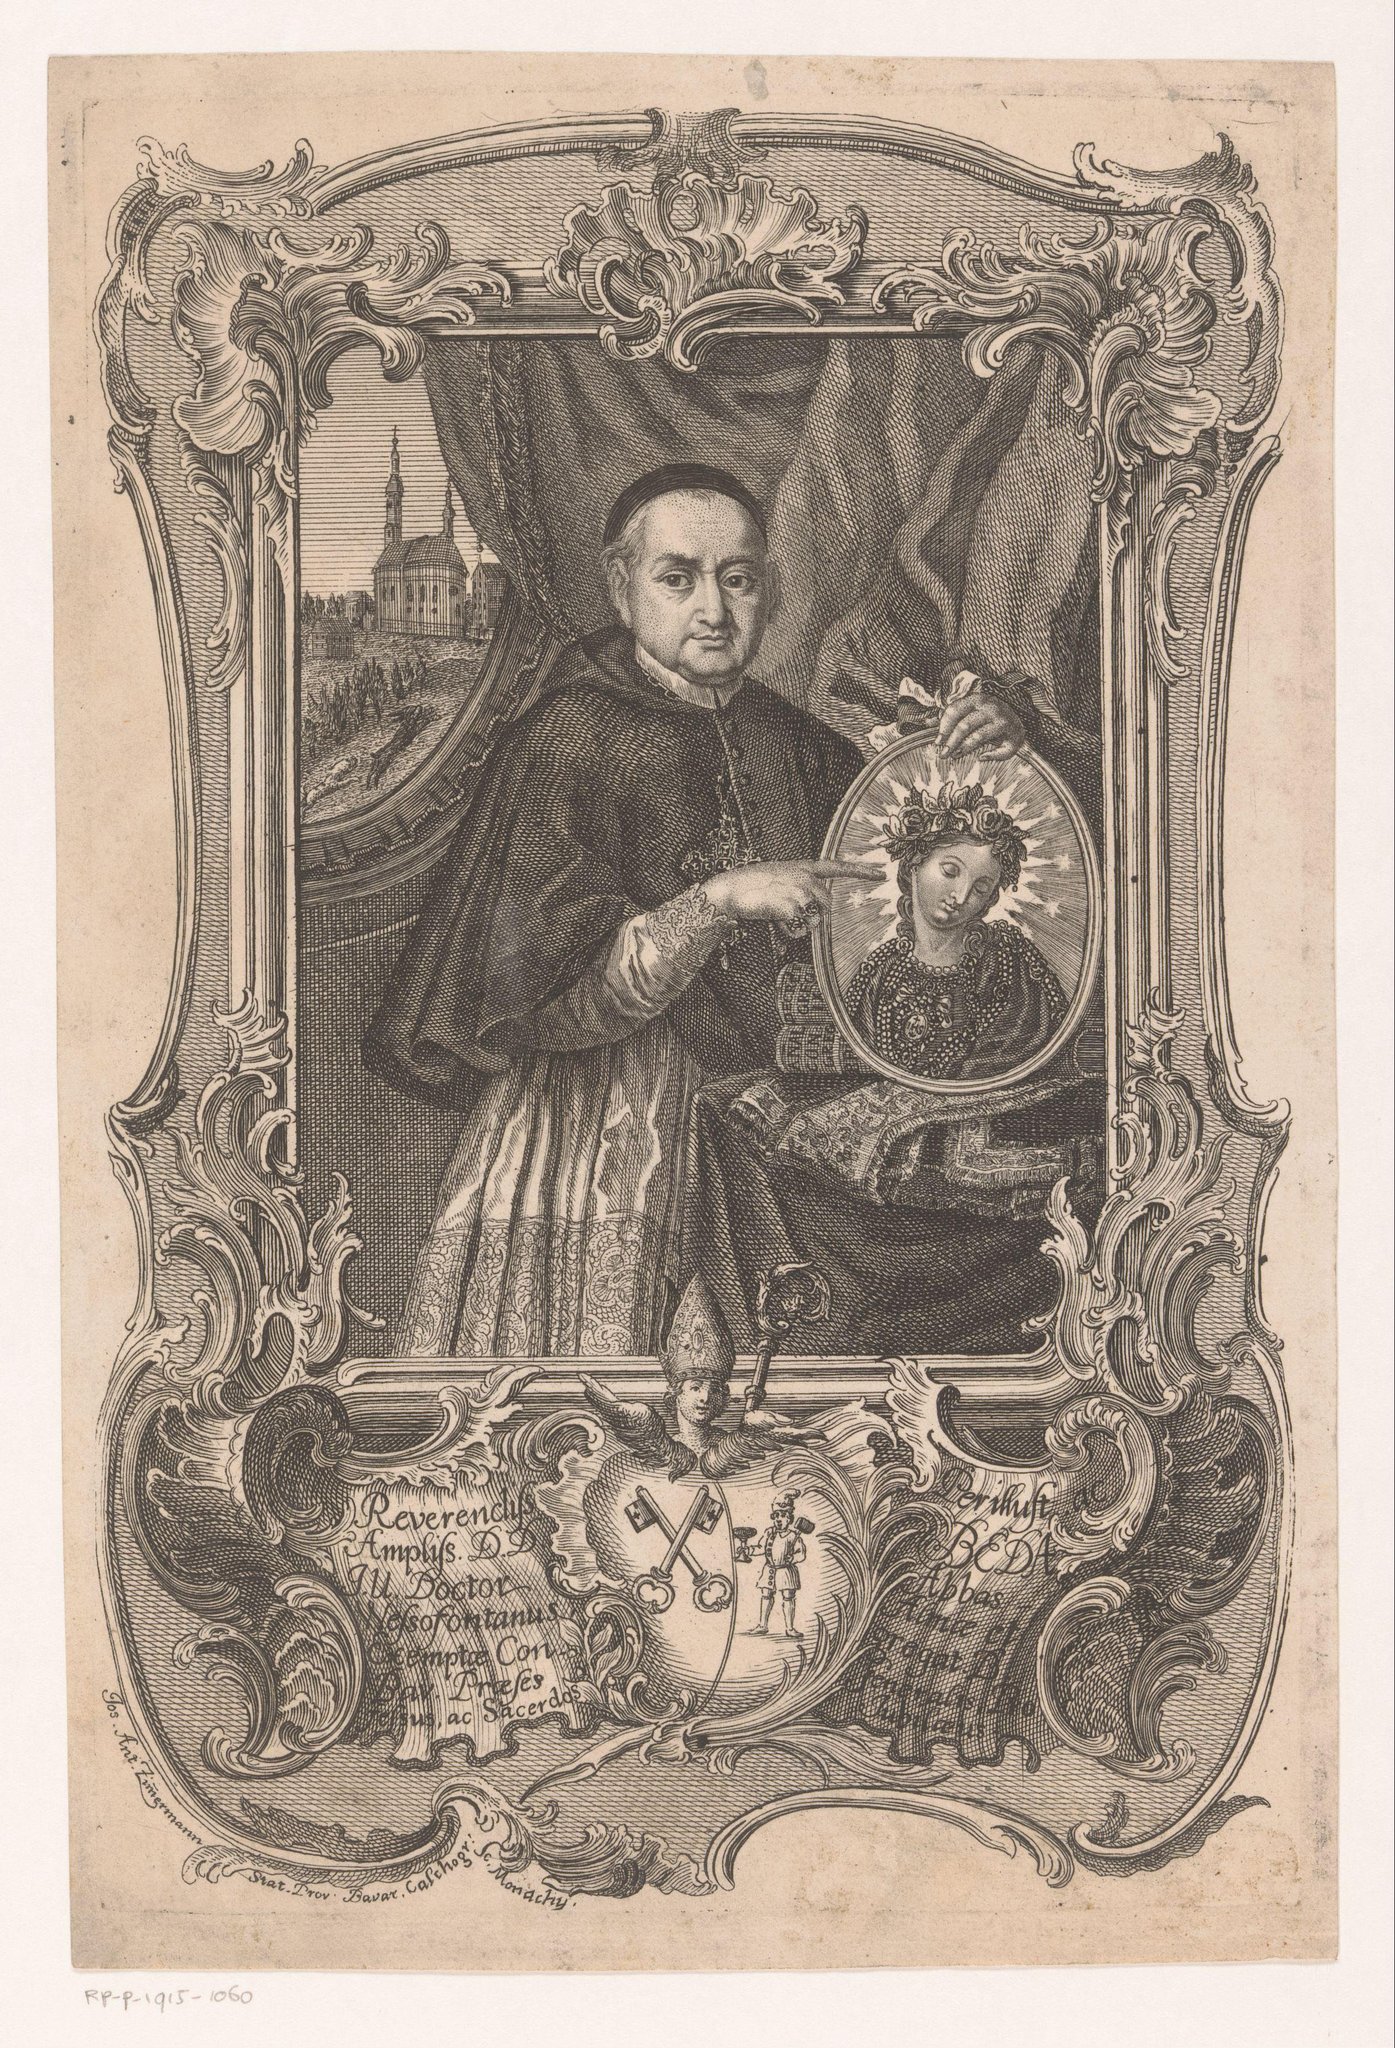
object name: print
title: Portret van Beda Abbas Wessofontanus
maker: joseph anton zimmermann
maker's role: draughtsman, print maker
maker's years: 1705-1797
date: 1715-1797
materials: paper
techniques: engraving, etching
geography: munich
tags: clergyman, historical persons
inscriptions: collector's mark: Lugt 2228